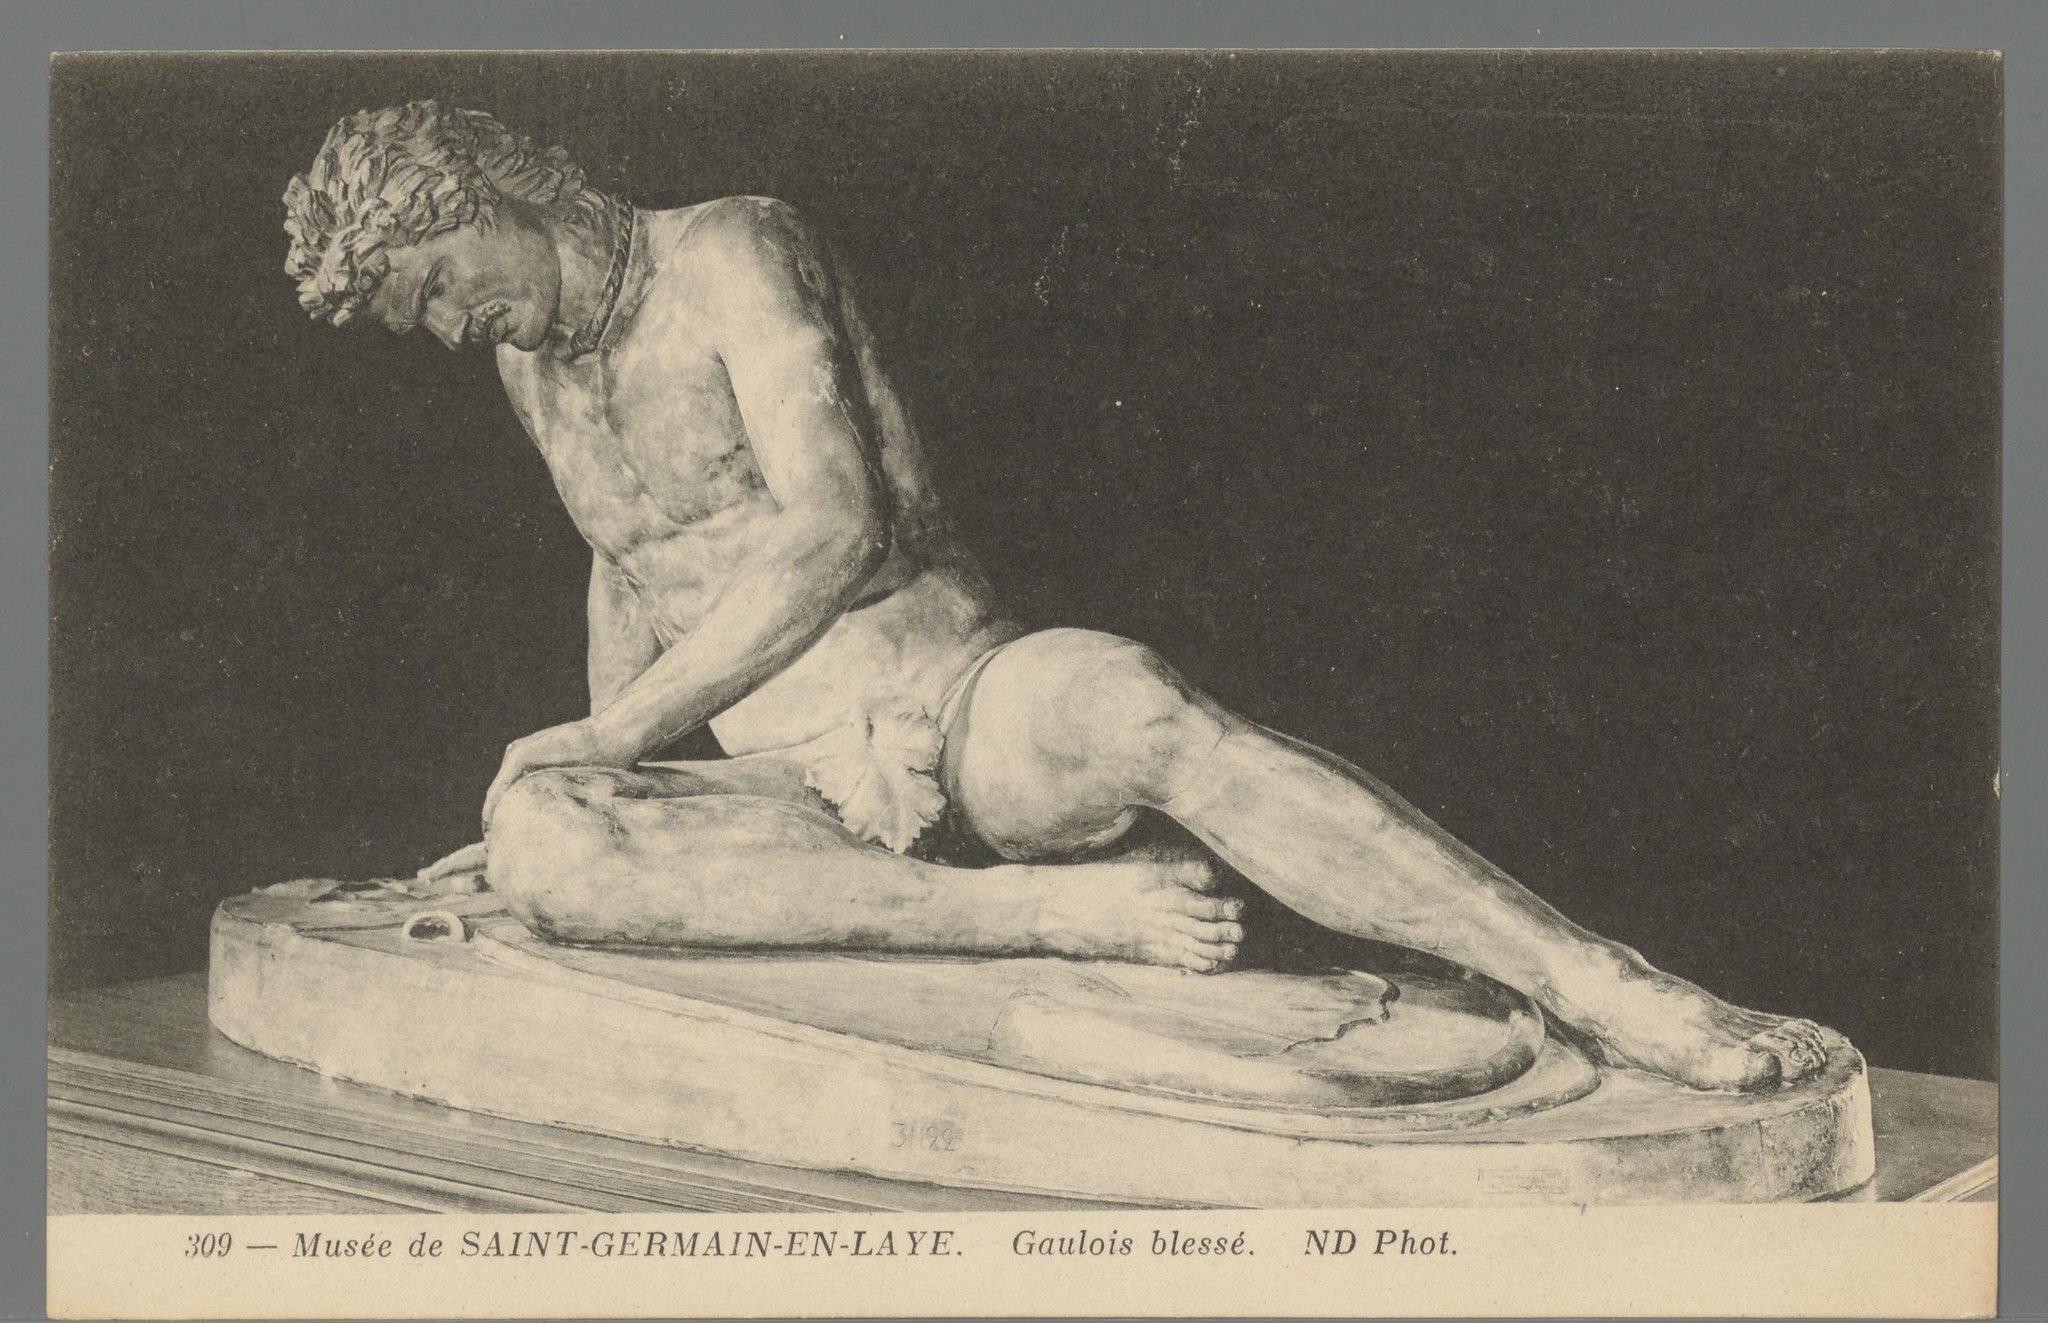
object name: ansichtkaart, prentbriefkaart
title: Musée de Saint-Germain-en-Laye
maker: Anonymous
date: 1903-1918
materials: cardboard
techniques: photograph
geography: paris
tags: permanent exhibition, museum, sculpture